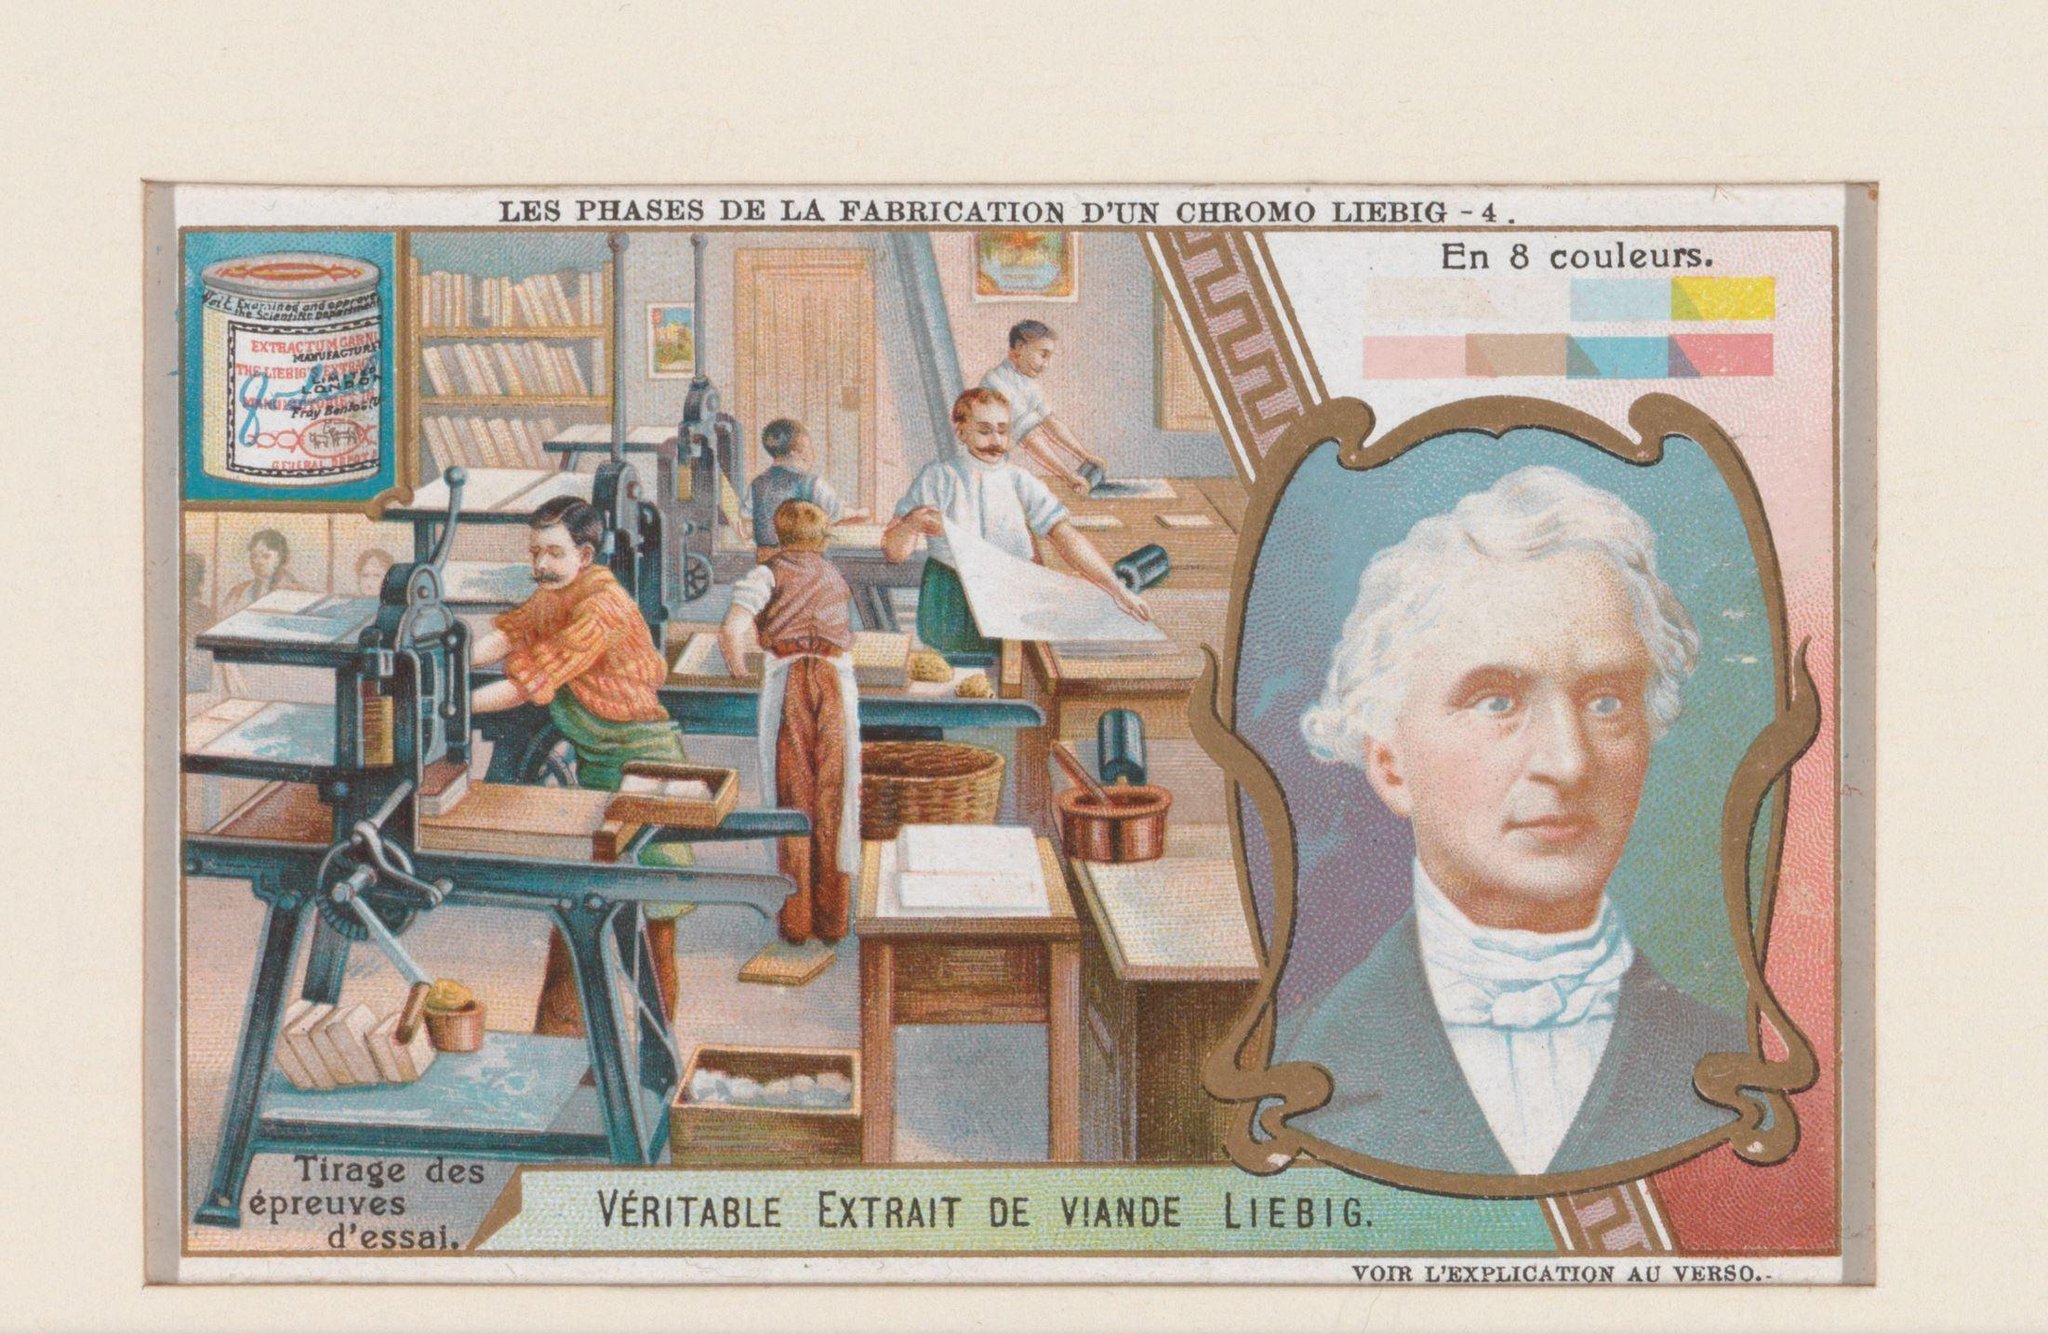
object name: print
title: Tirages des épreuves d'essai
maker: Anonymous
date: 1906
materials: paper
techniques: chromolithography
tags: lithographer, historical persons, printing press, tools, implements of graphic artist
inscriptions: title: ‘Tirages des épreuves d'essai’, title: ‘VÉRITABLE EXTRAIT DE VIANDE LIEBIG.’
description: Drukkerswerkplaats met mannen achter persen.